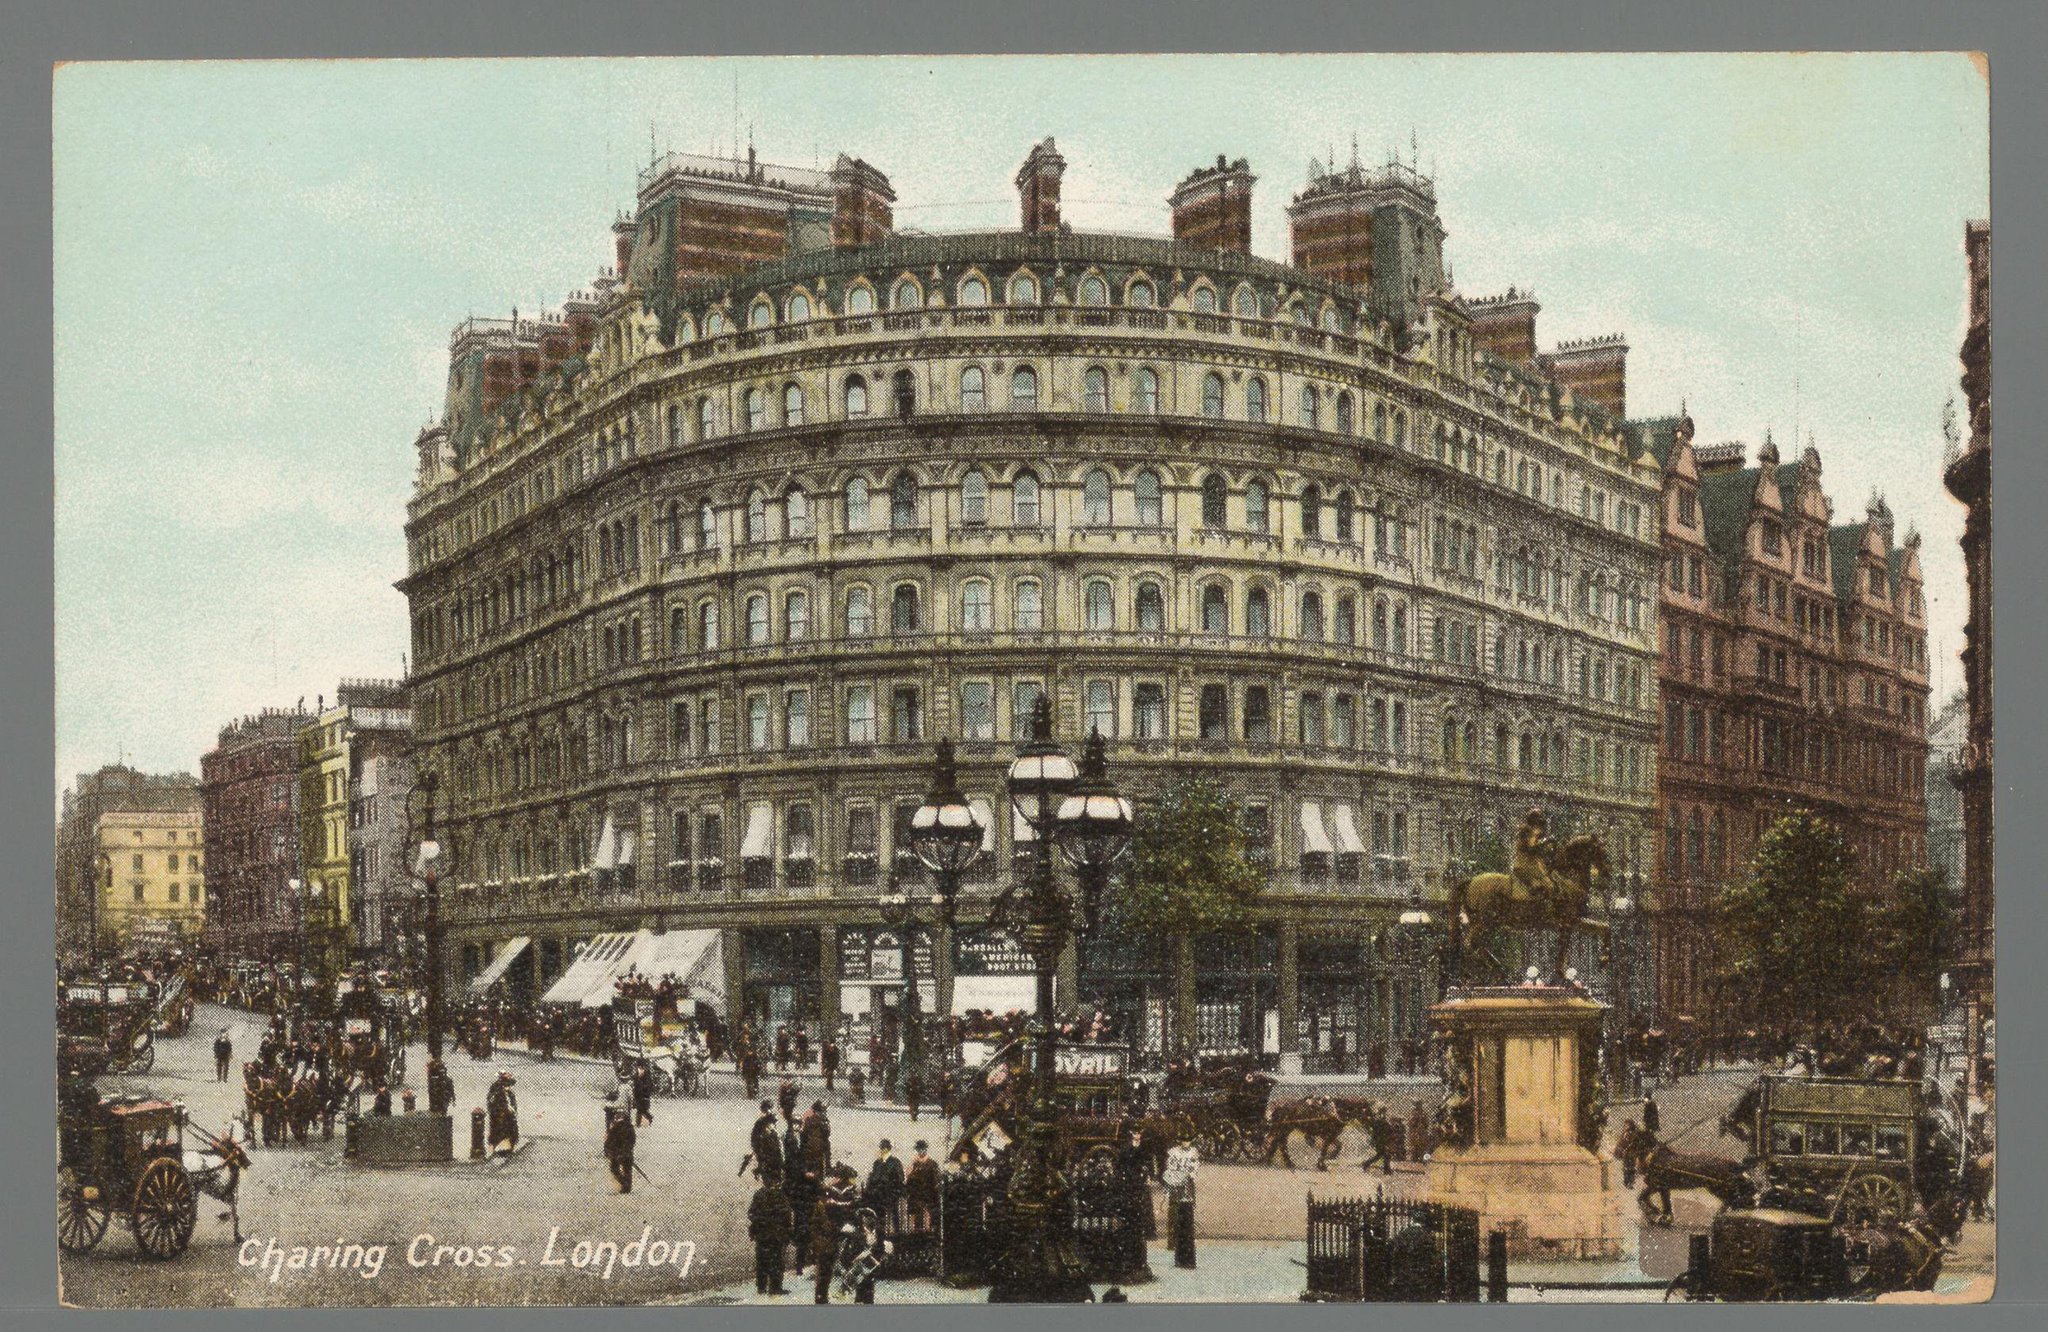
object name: ansichtkaart, prentbriefkaart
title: Charing Cross. London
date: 1903-1916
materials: cardboard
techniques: lithograph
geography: london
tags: monument, statue, street